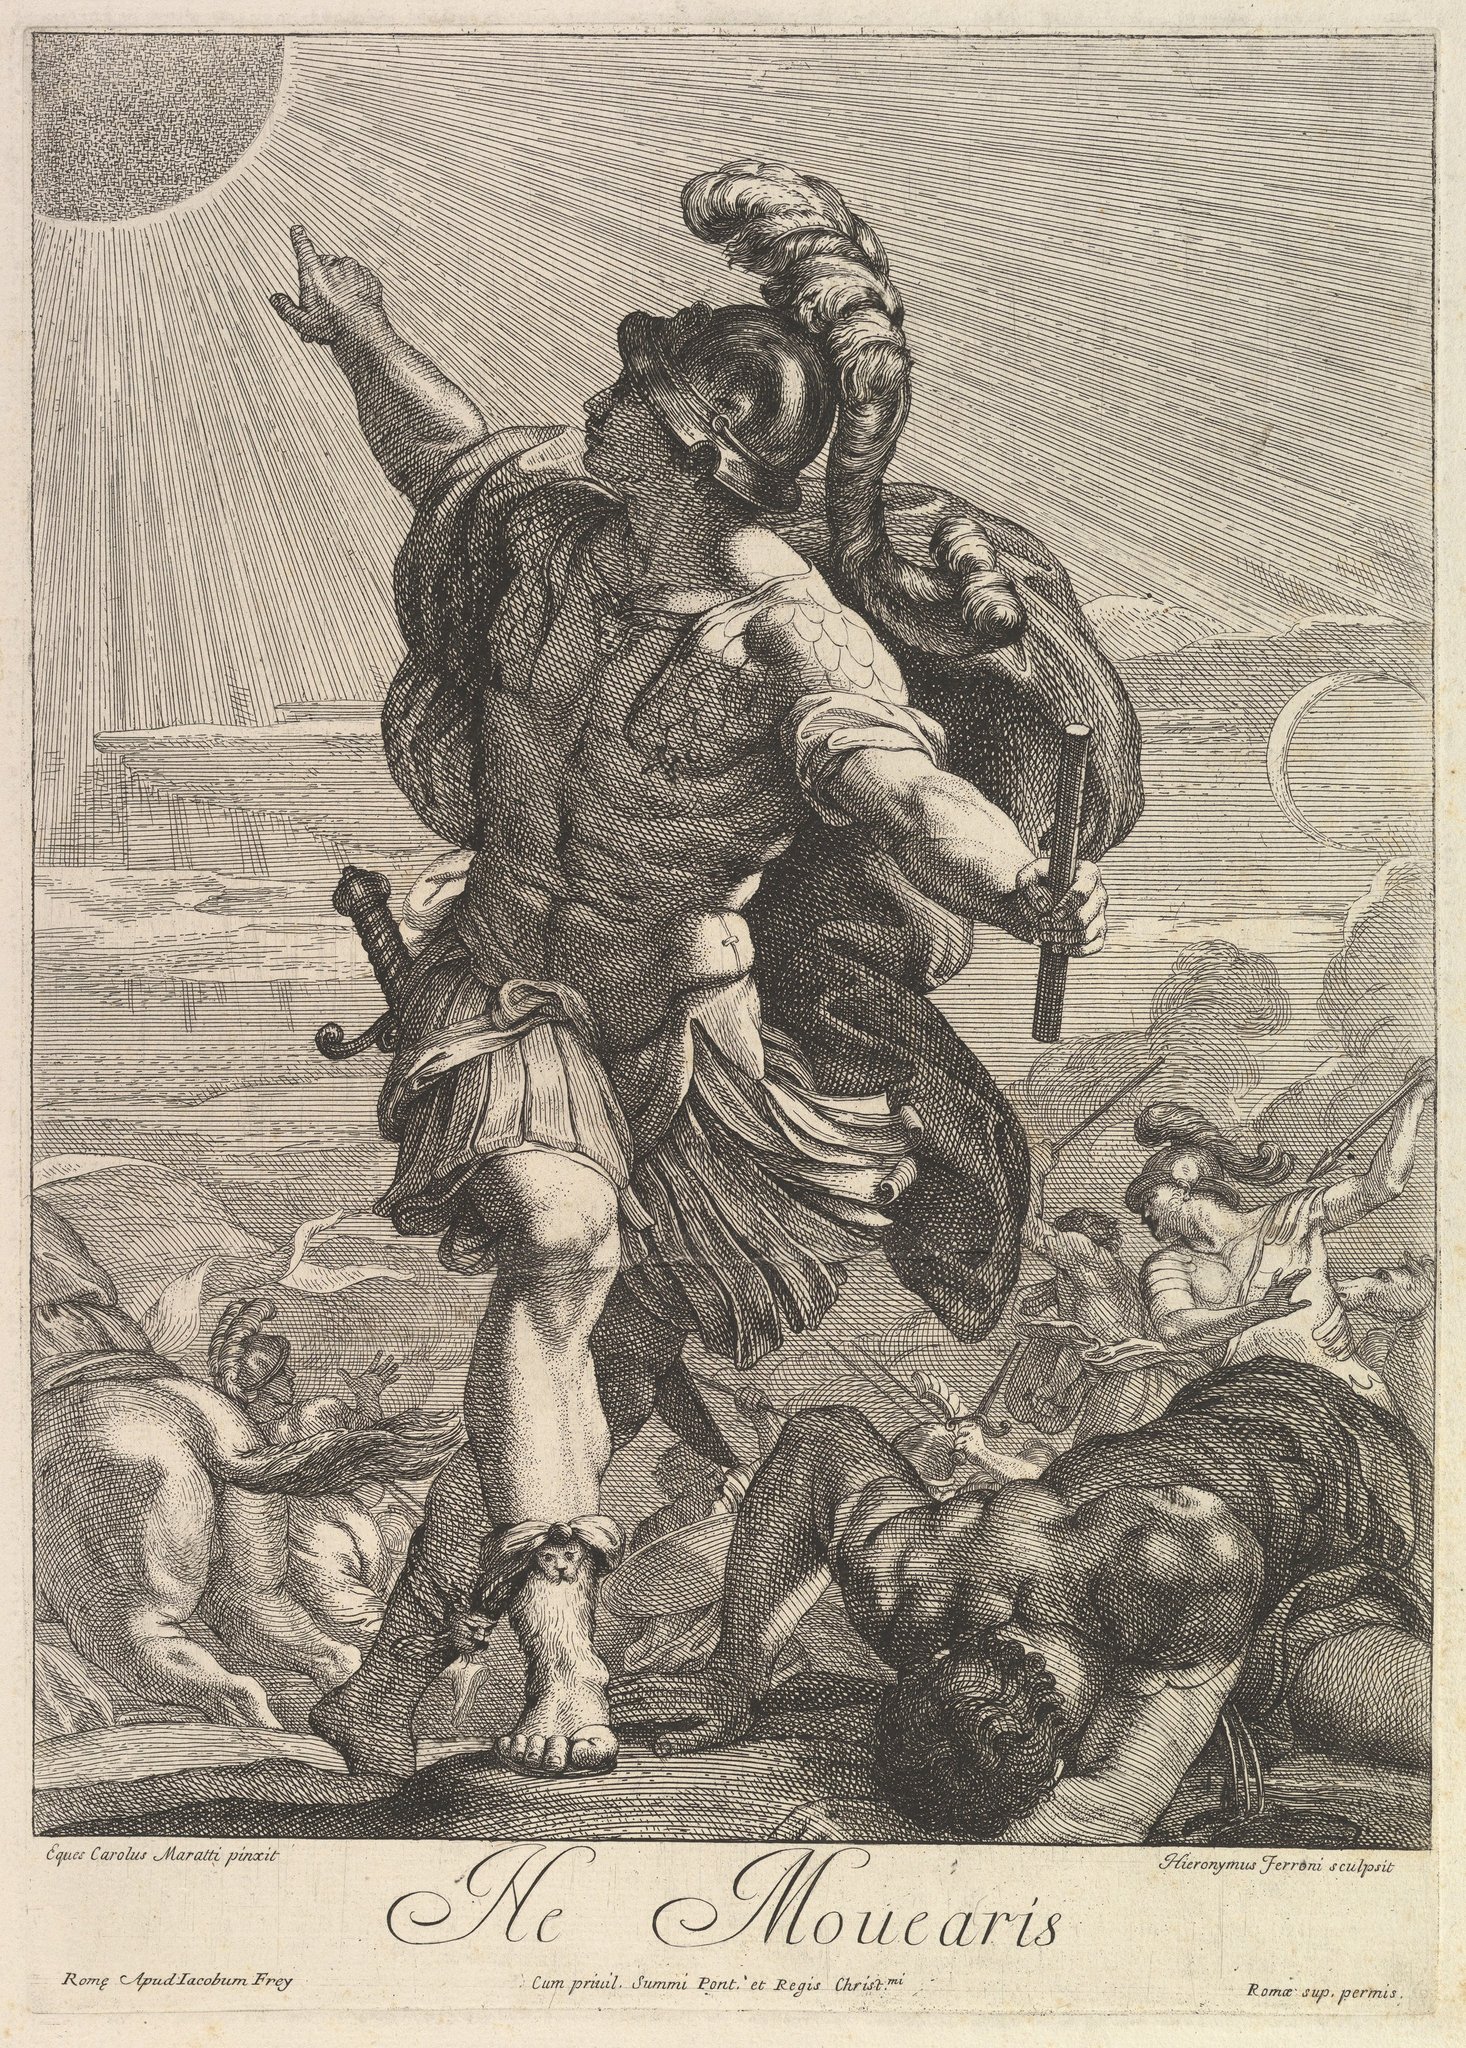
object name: print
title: Joshua commanding the sun to stand still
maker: hieronymus ferroni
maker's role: artist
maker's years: 1687-1730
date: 1687-1730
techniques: etching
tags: sun,joshua